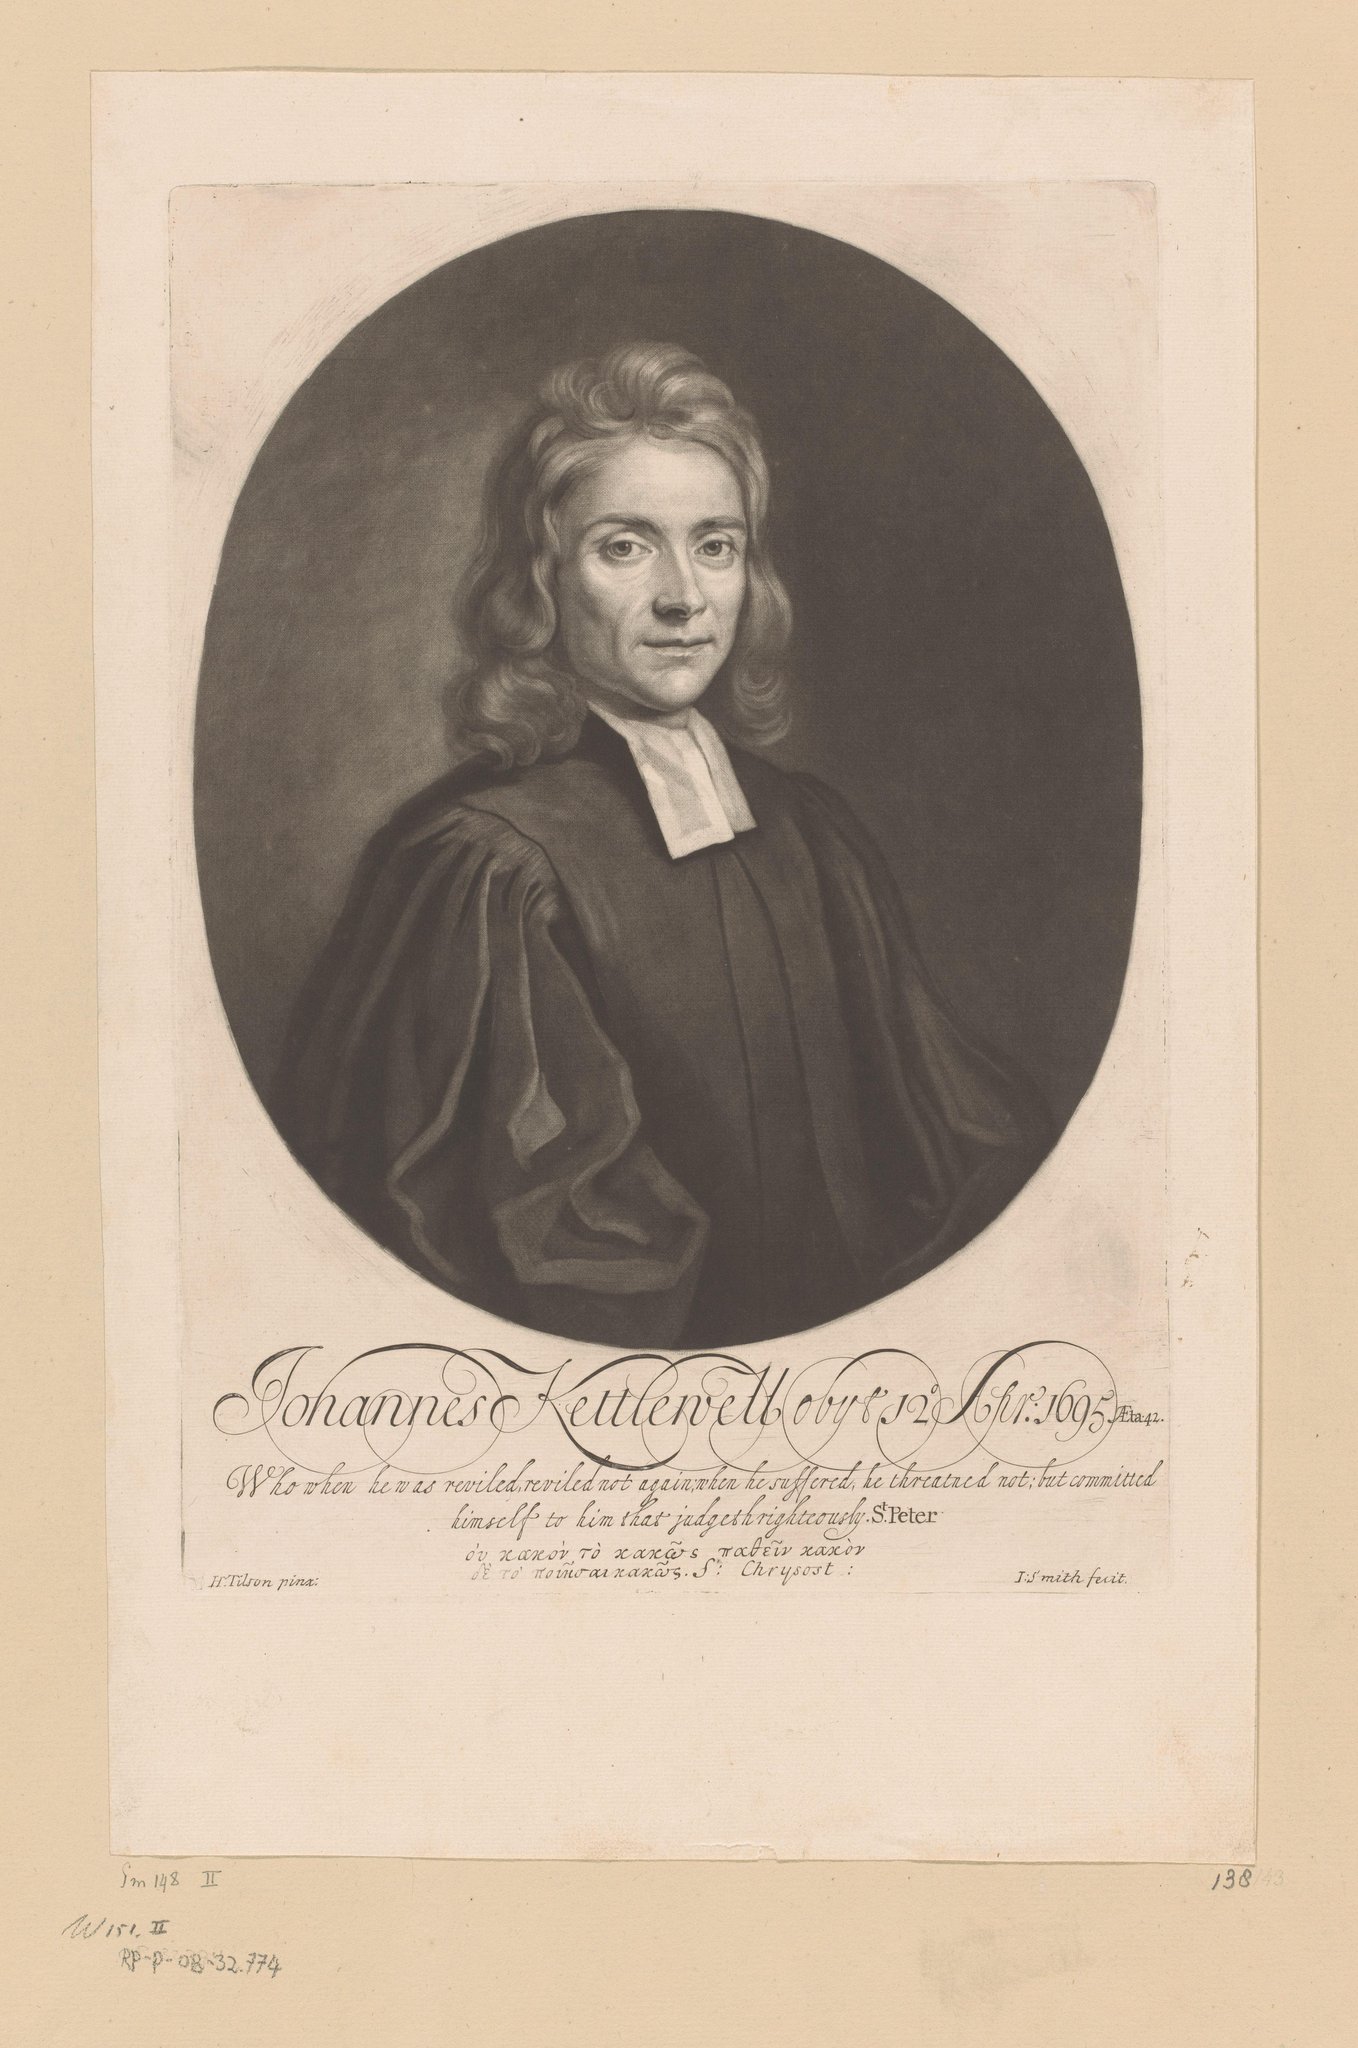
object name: print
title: Portret van John Kettlewell op 42-jarige leeftijd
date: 1695-1742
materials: paper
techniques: mezzotint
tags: priest, theologian, historical persons, portrait of a writer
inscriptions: collector's mark: Lugt 1842, collector's mark: Lugt 240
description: Tekst in het Engels en het Grieks in de ondermarge.